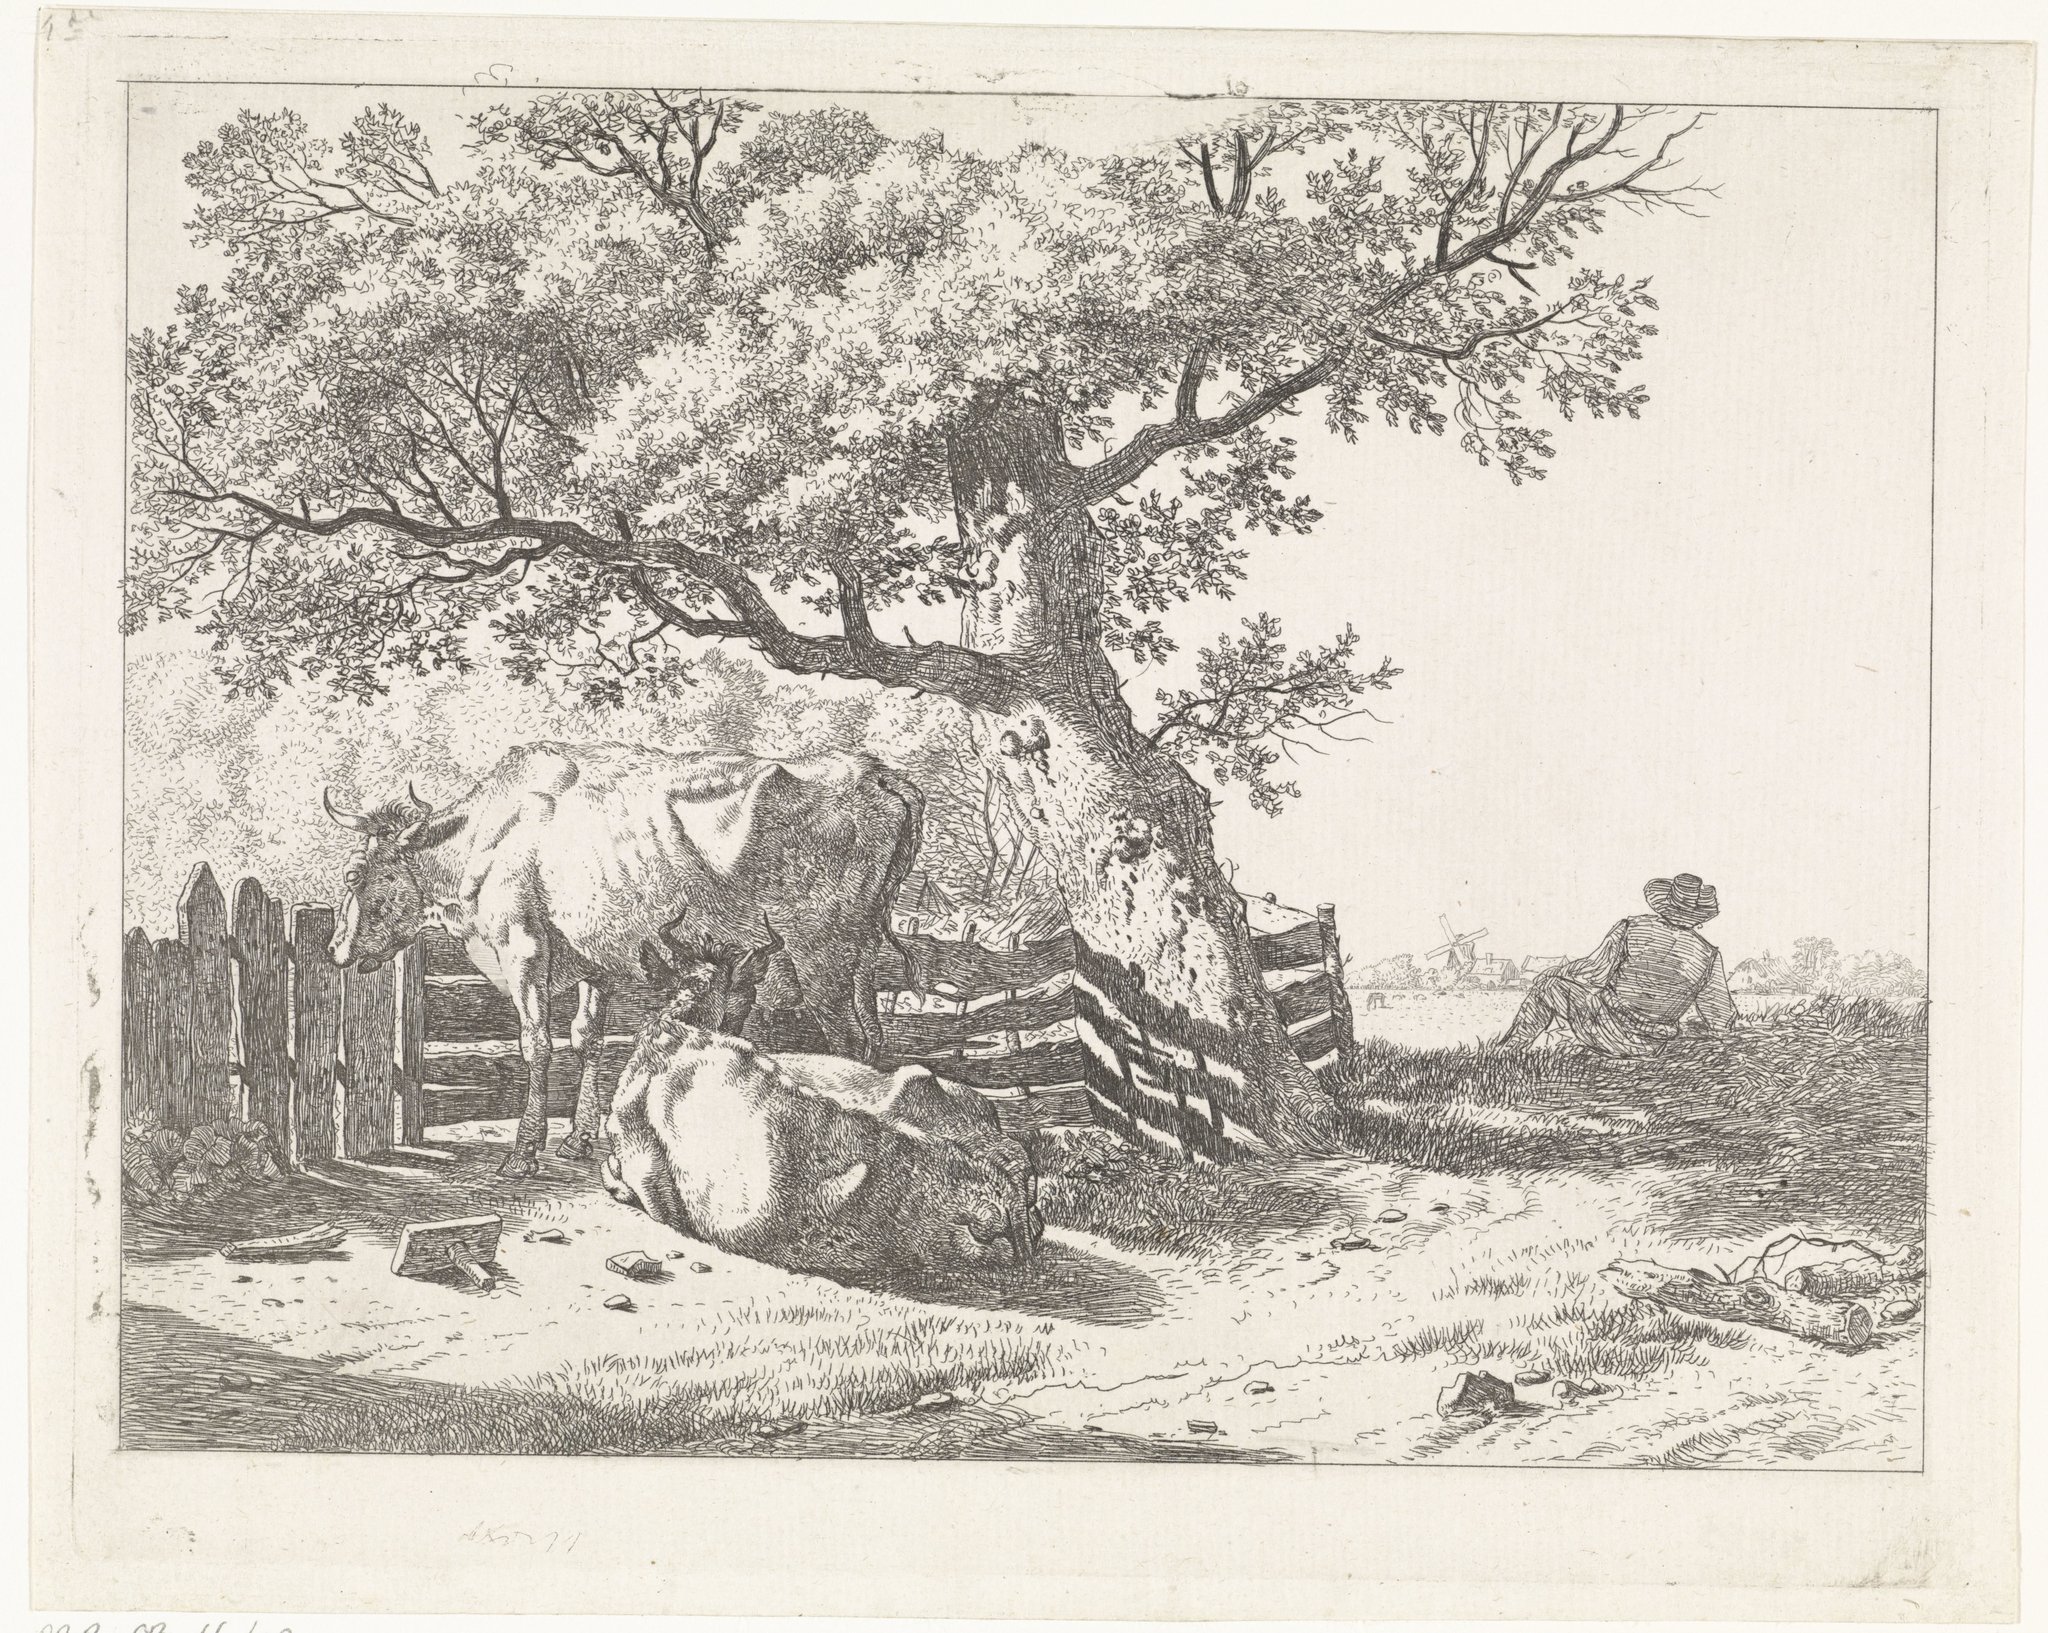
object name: print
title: Twee koeien bij een hek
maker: wouter johannes van troostwijk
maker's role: draughtsman, painter, print maker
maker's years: 1782-1810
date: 1792-1810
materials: paper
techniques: etching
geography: amsterdam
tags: trees, cow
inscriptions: collector's mark: Lugt 2165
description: Twee koeien bij een hek naast een boom. Rechts zit een man, op de rug gezien, in het gras.